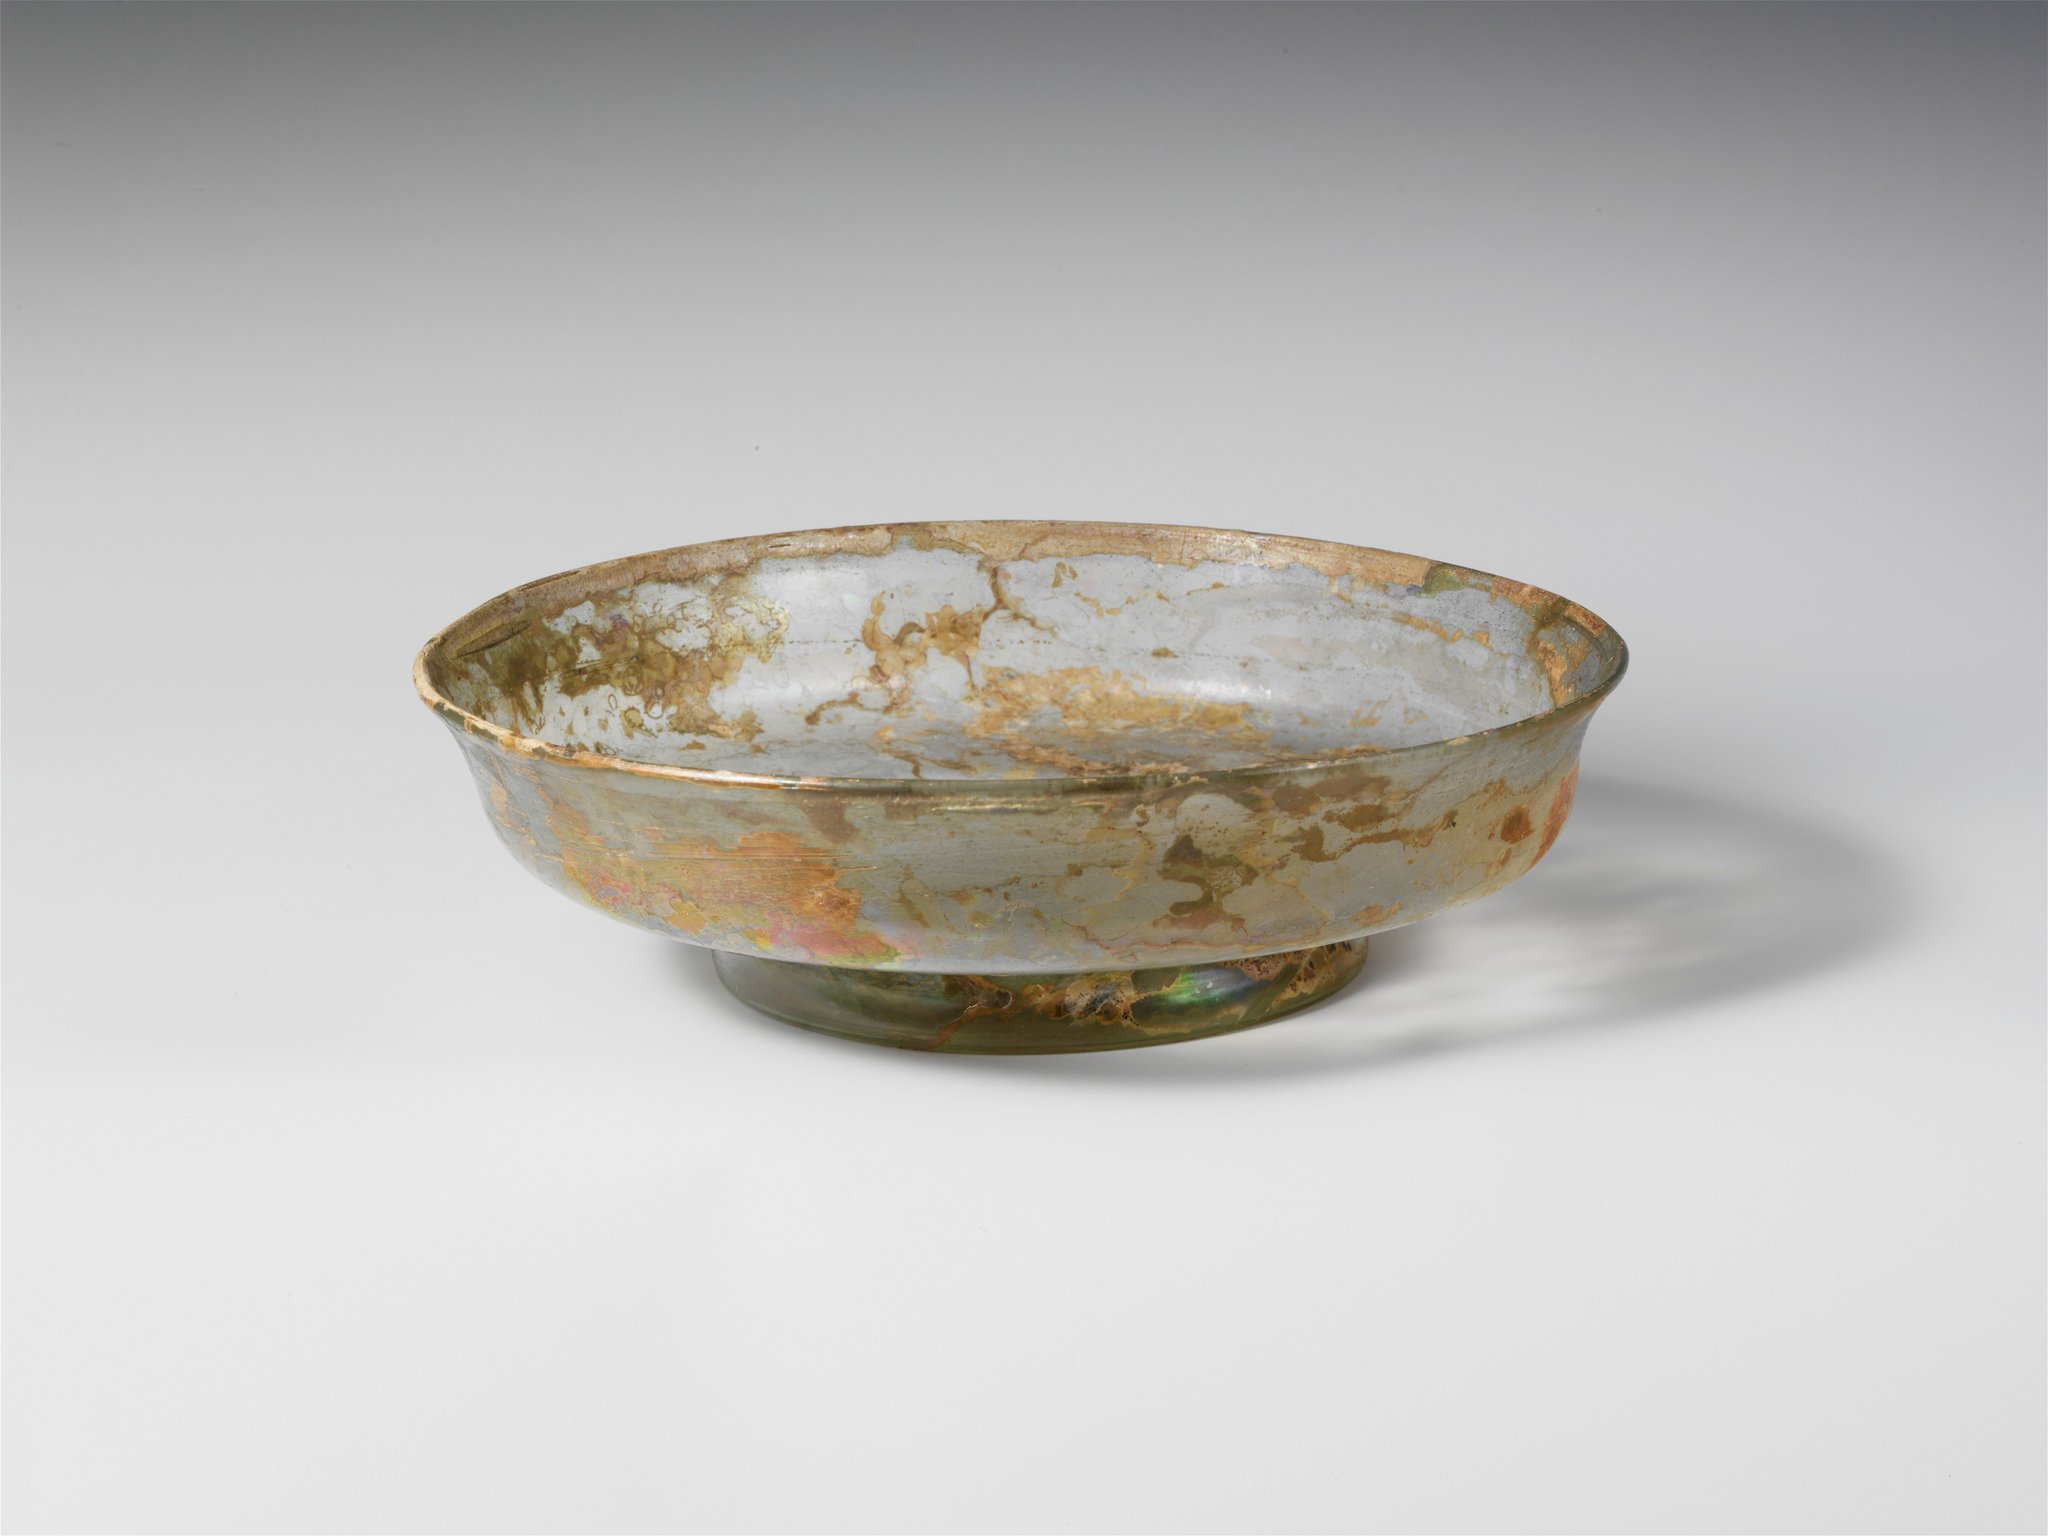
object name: dish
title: Glass dish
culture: roman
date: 301-400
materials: glass